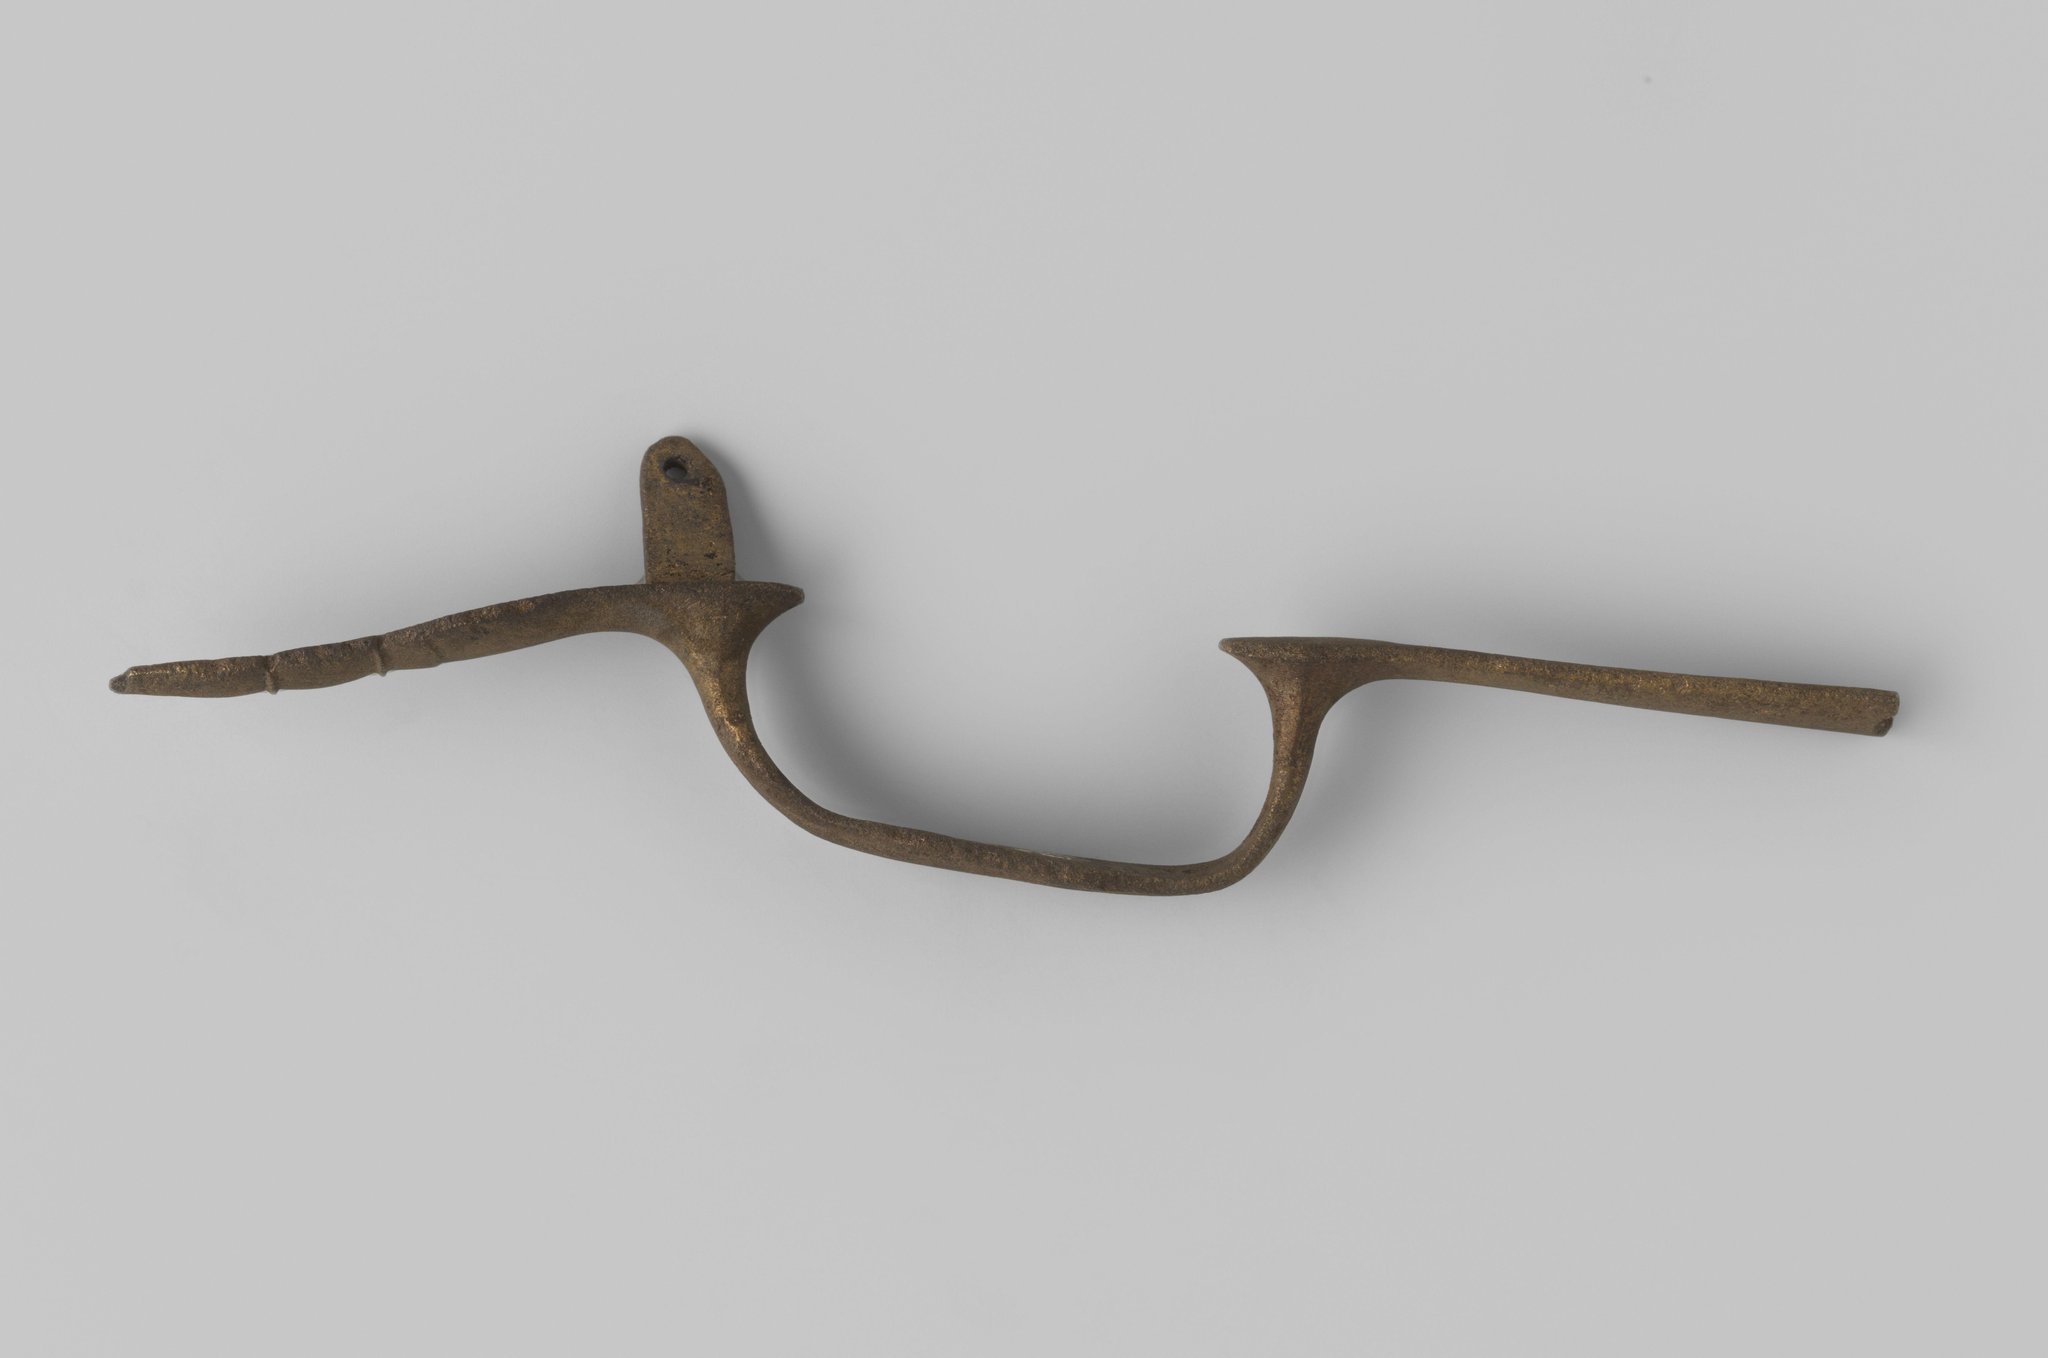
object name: musket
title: Trekkerbeugel van een musket uit het wrak van de Oost-Indiëvaarder Hollandia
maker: Anonymous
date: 1700-1743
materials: copper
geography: netherlands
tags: verenigde oostindische compagnie, hollandia (schip), annet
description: Musket, trigger guard; fragm, id. NG 1980-27H2613, rear end (tang) broken off at circular fitting eye, underneath front leg of pontet vertical projection with semicircular pierced end.